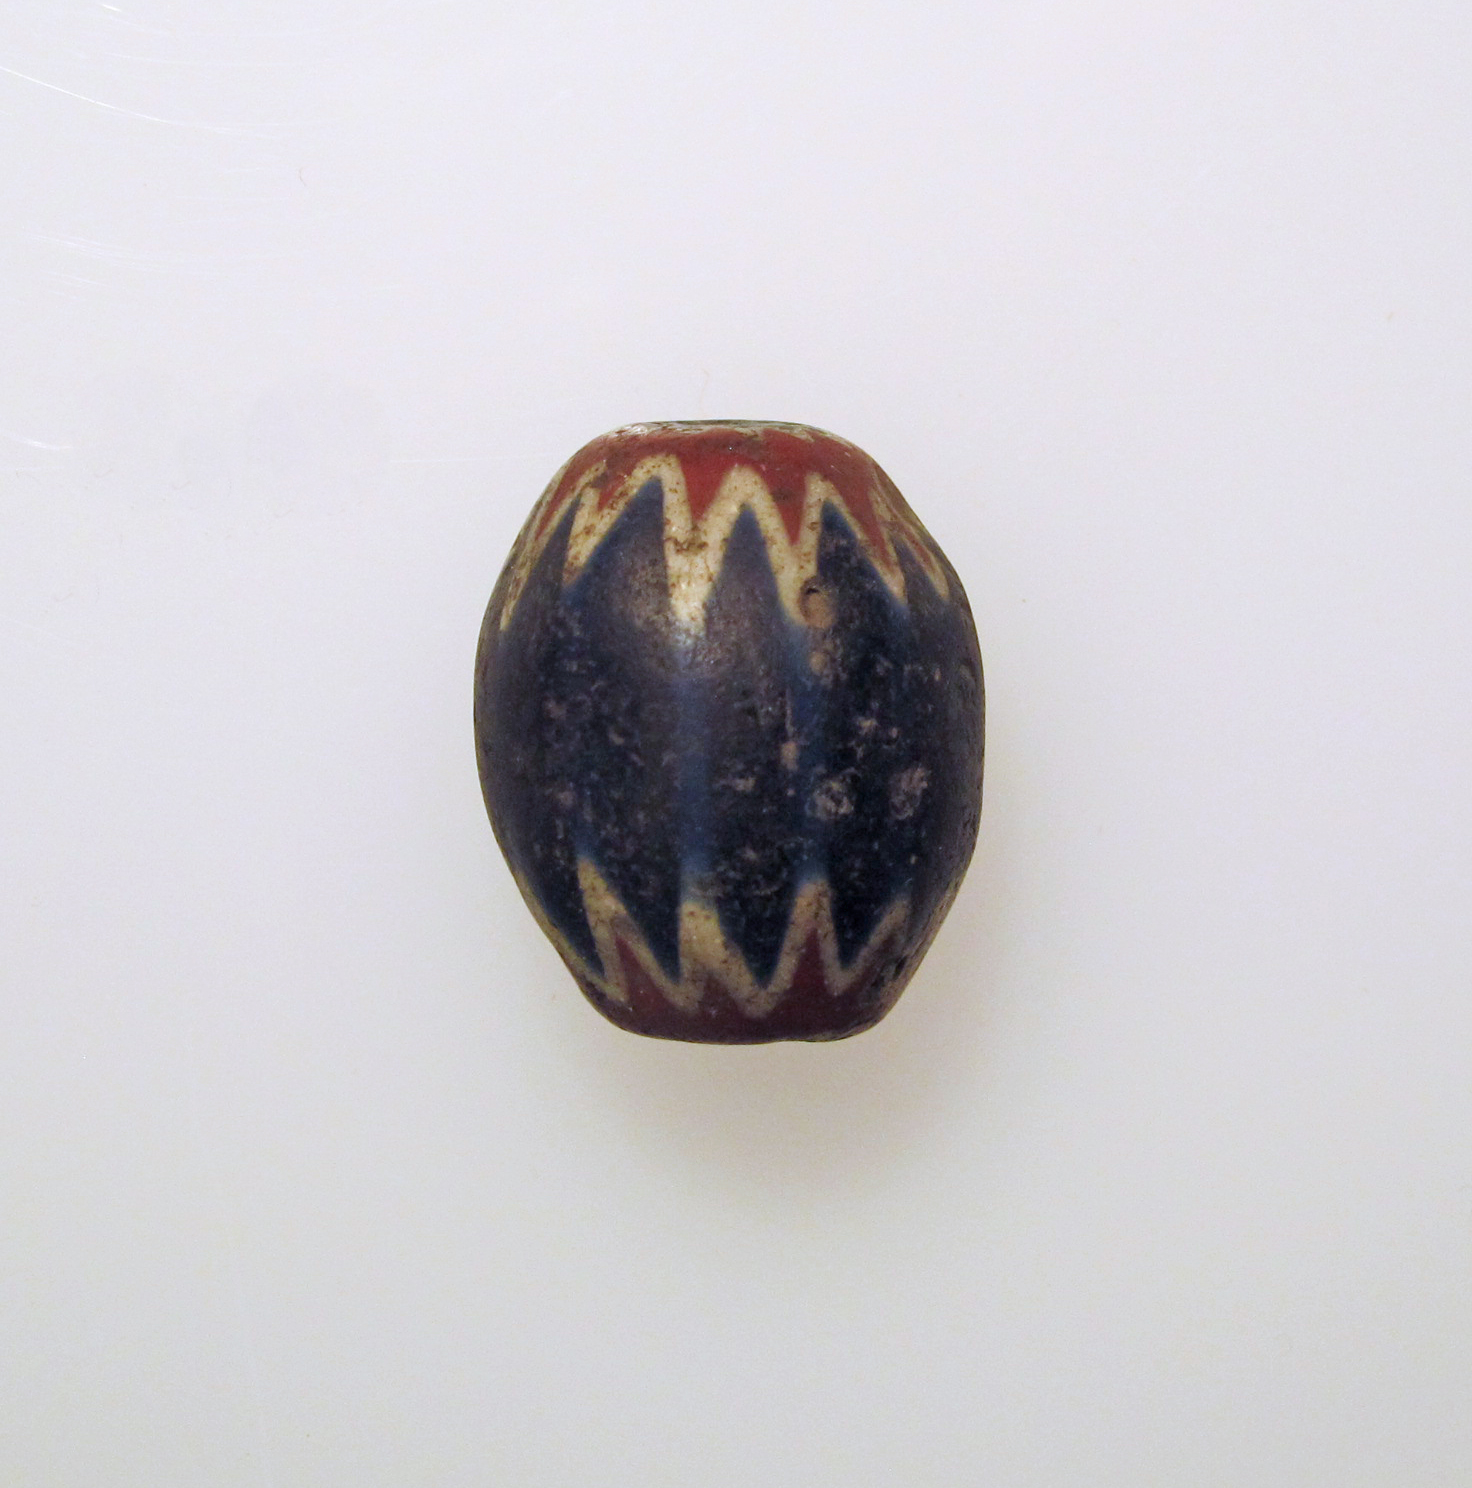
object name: chevron bead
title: Glass chevron bead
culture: venetian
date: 900-100 BCE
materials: glass